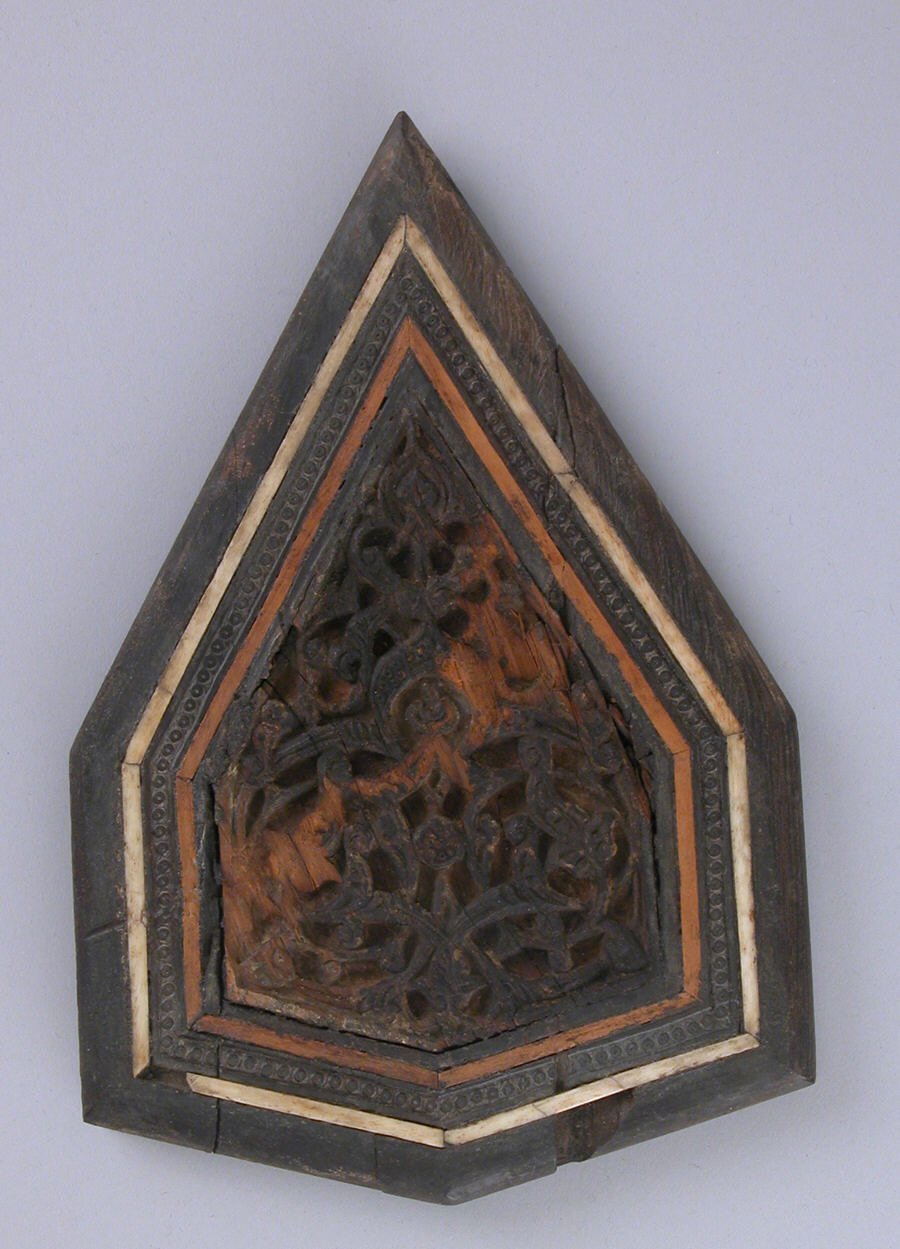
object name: panel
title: Panel from a Minbar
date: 1201-1400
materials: ivory, paint, wood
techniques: carving, inlay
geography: egypt